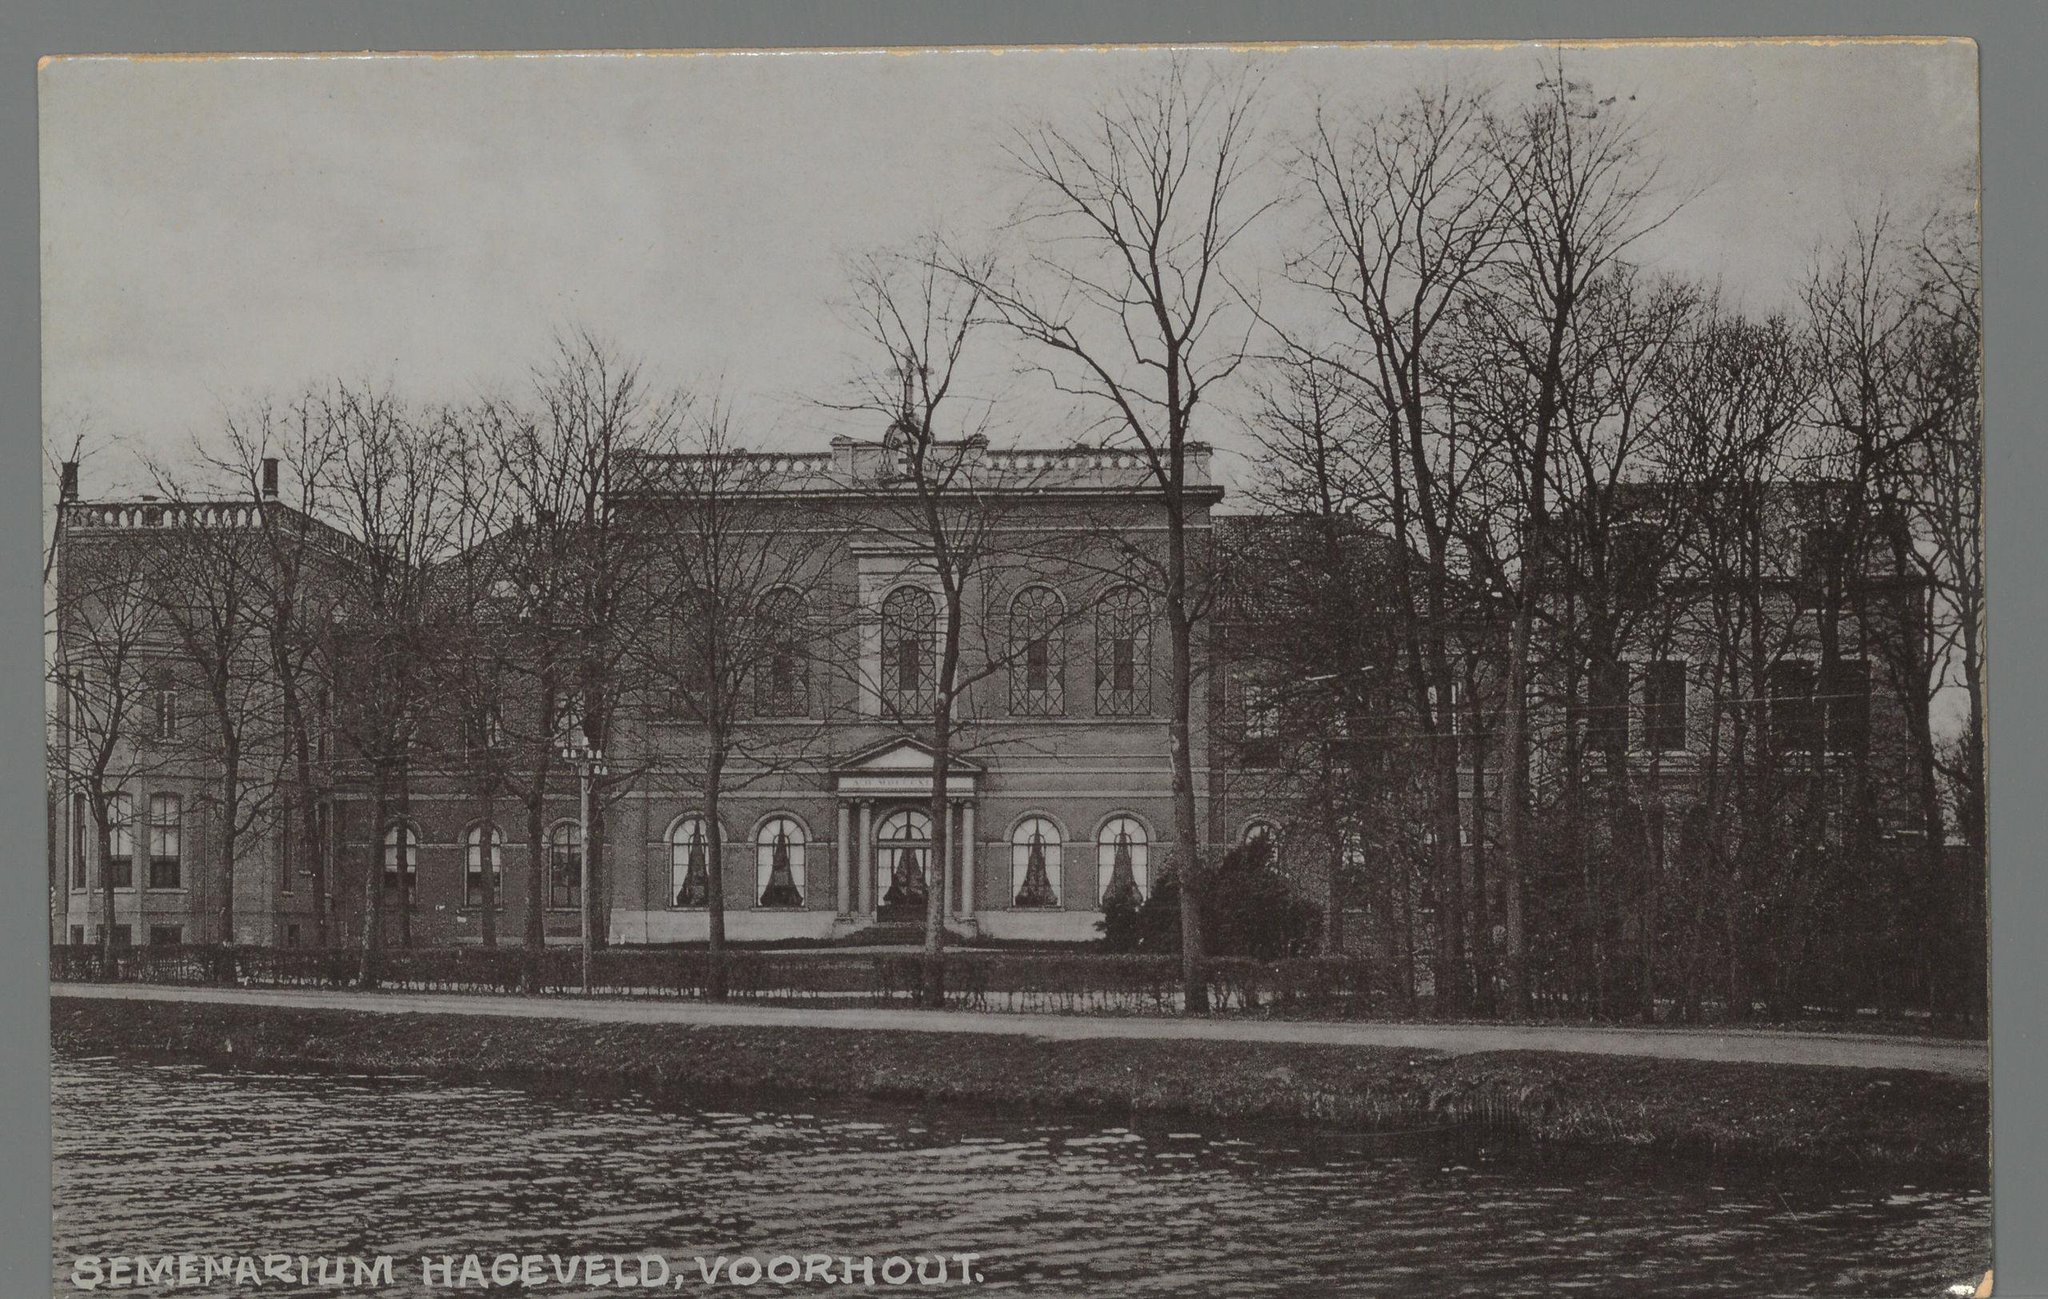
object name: ansichtkaart, prentbriefkaart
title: Semenarium Hageveld, Voorhout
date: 1905-1930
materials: cardboard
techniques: photograph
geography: voorhout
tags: institution for ecclesiastical education and training, e.g. seminary